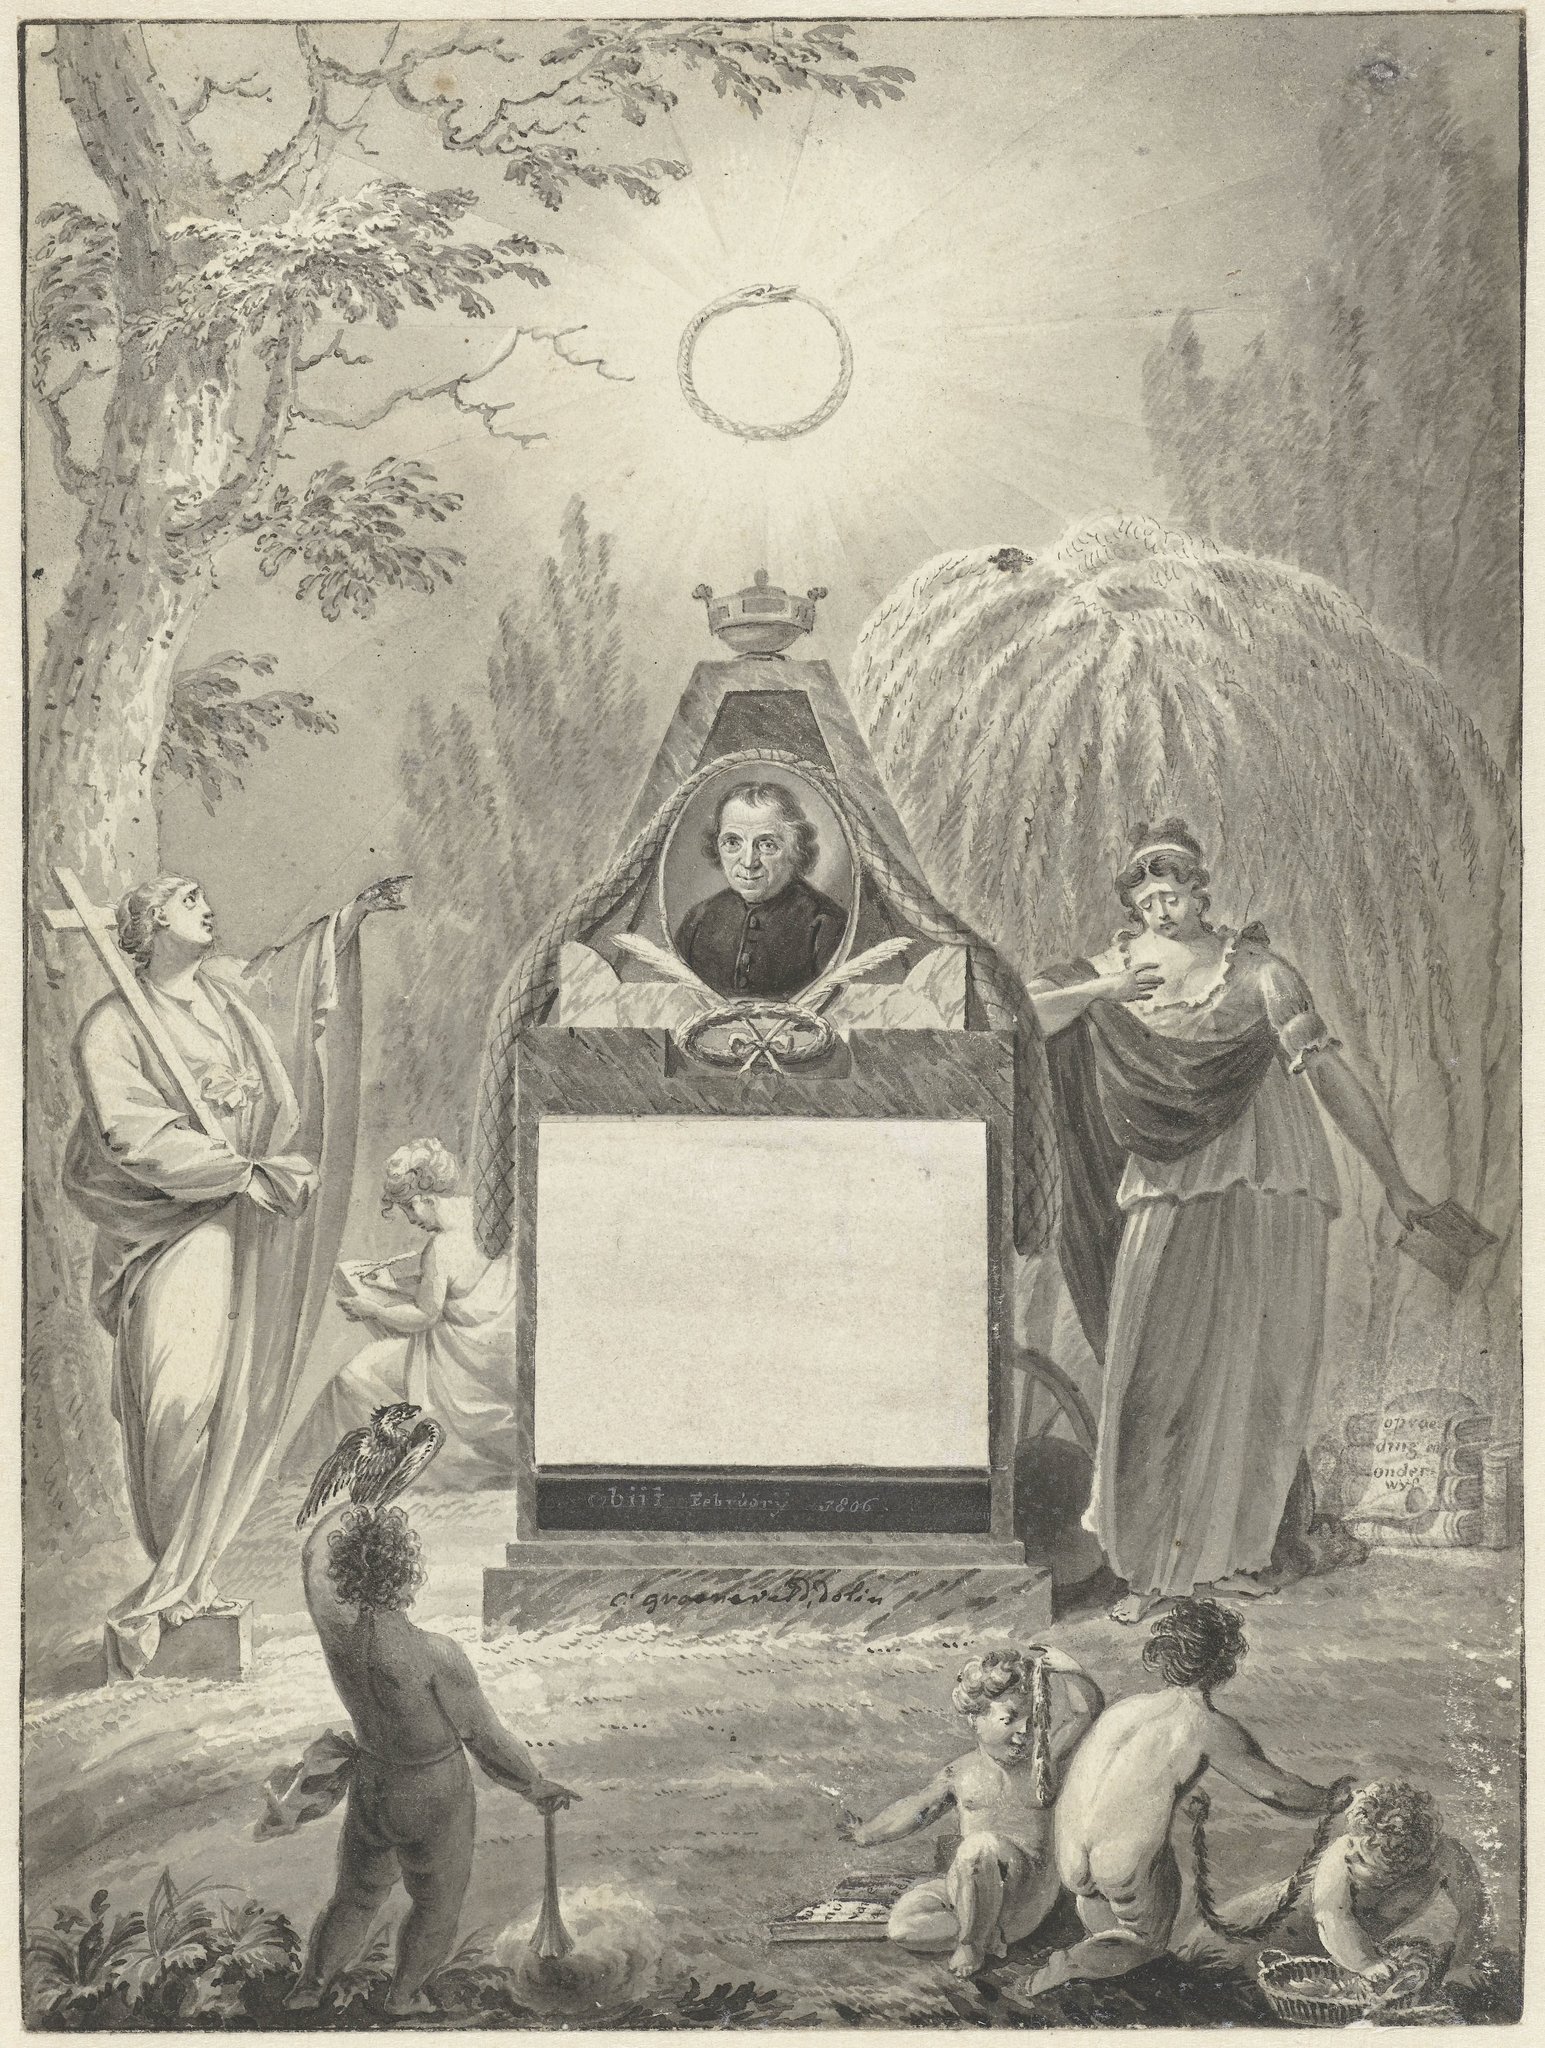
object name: design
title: Ontwerp voor een gedenkprent voor Jan Nieuwenhuysen, stichter van de Maatschappij tot Nut van 't Algemeen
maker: cornelis groeneveld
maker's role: draughtsman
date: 1806-1813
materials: ink, paper, pencil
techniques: brush, pen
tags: haarlem, amsterdam, jan nieuwenhuyzen, historical persons, grave-building, monumental tomb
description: Ontwerp voor een gedenkprent voor Jan Nieuwenhuysen, stichter van de Maatschappij tot Nut van 't Algemeen, overleden 25 februari 1806.